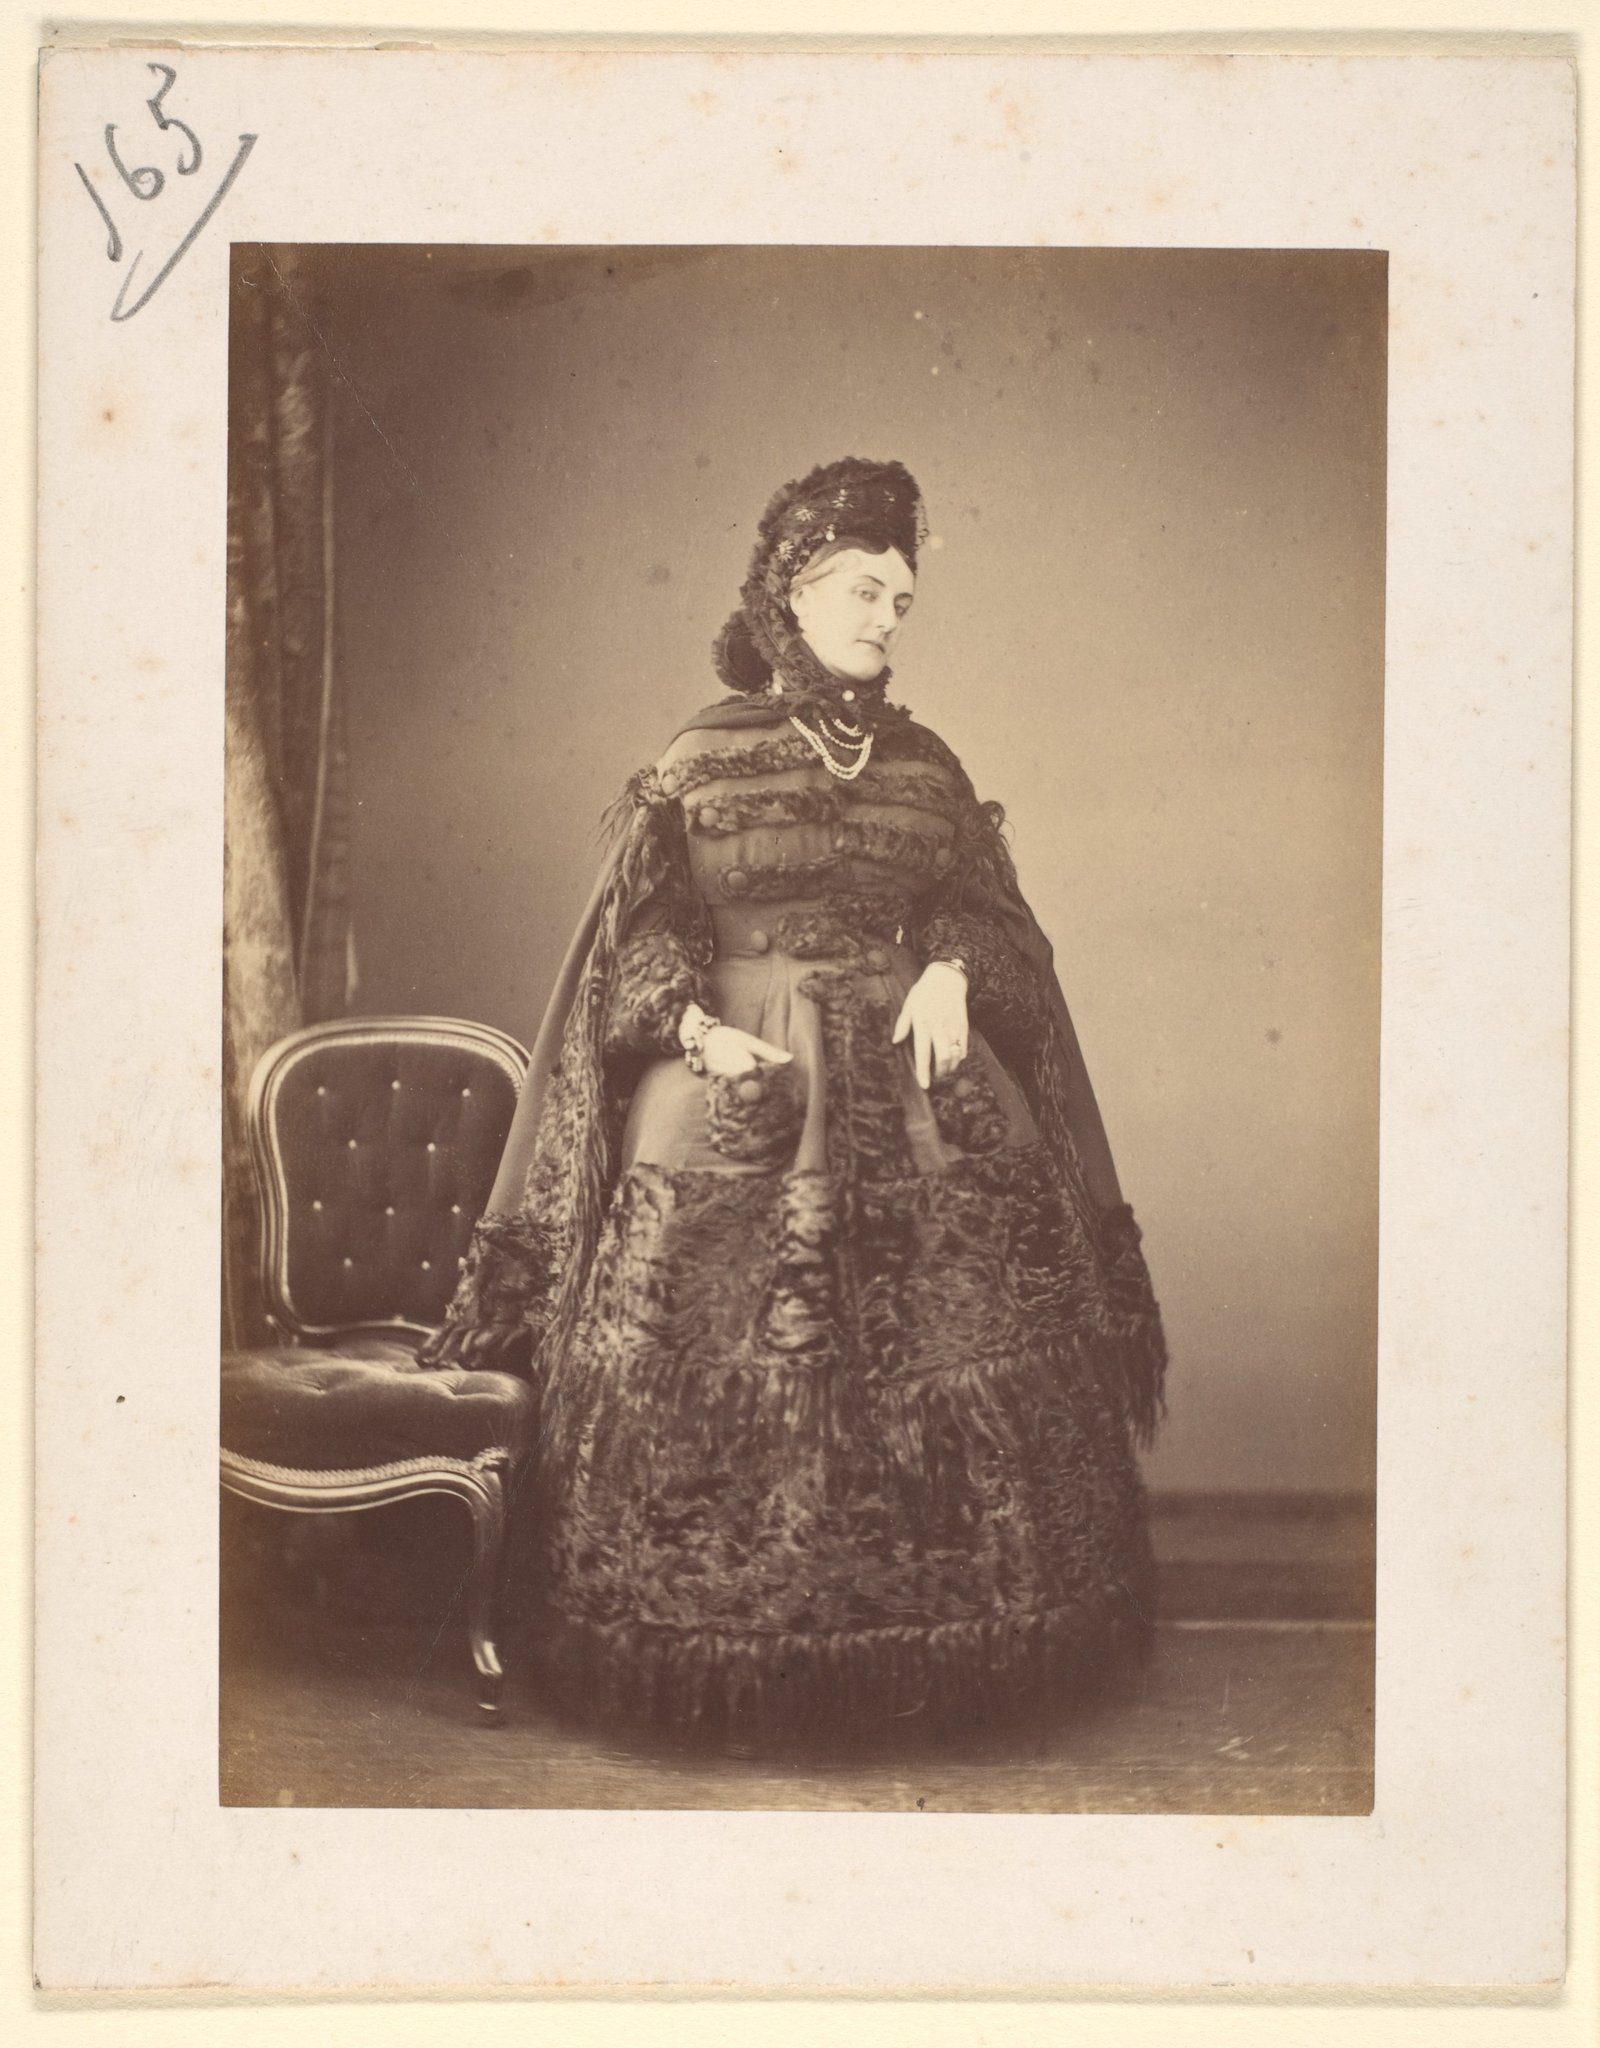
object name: photograph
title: Le Caracul (L'Astrakhan)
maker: pierre-louis pierson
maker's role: artist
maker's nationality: french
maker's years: 1822-1913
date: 1860-1869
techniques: albumen silver print, glass negative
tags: portraits,women